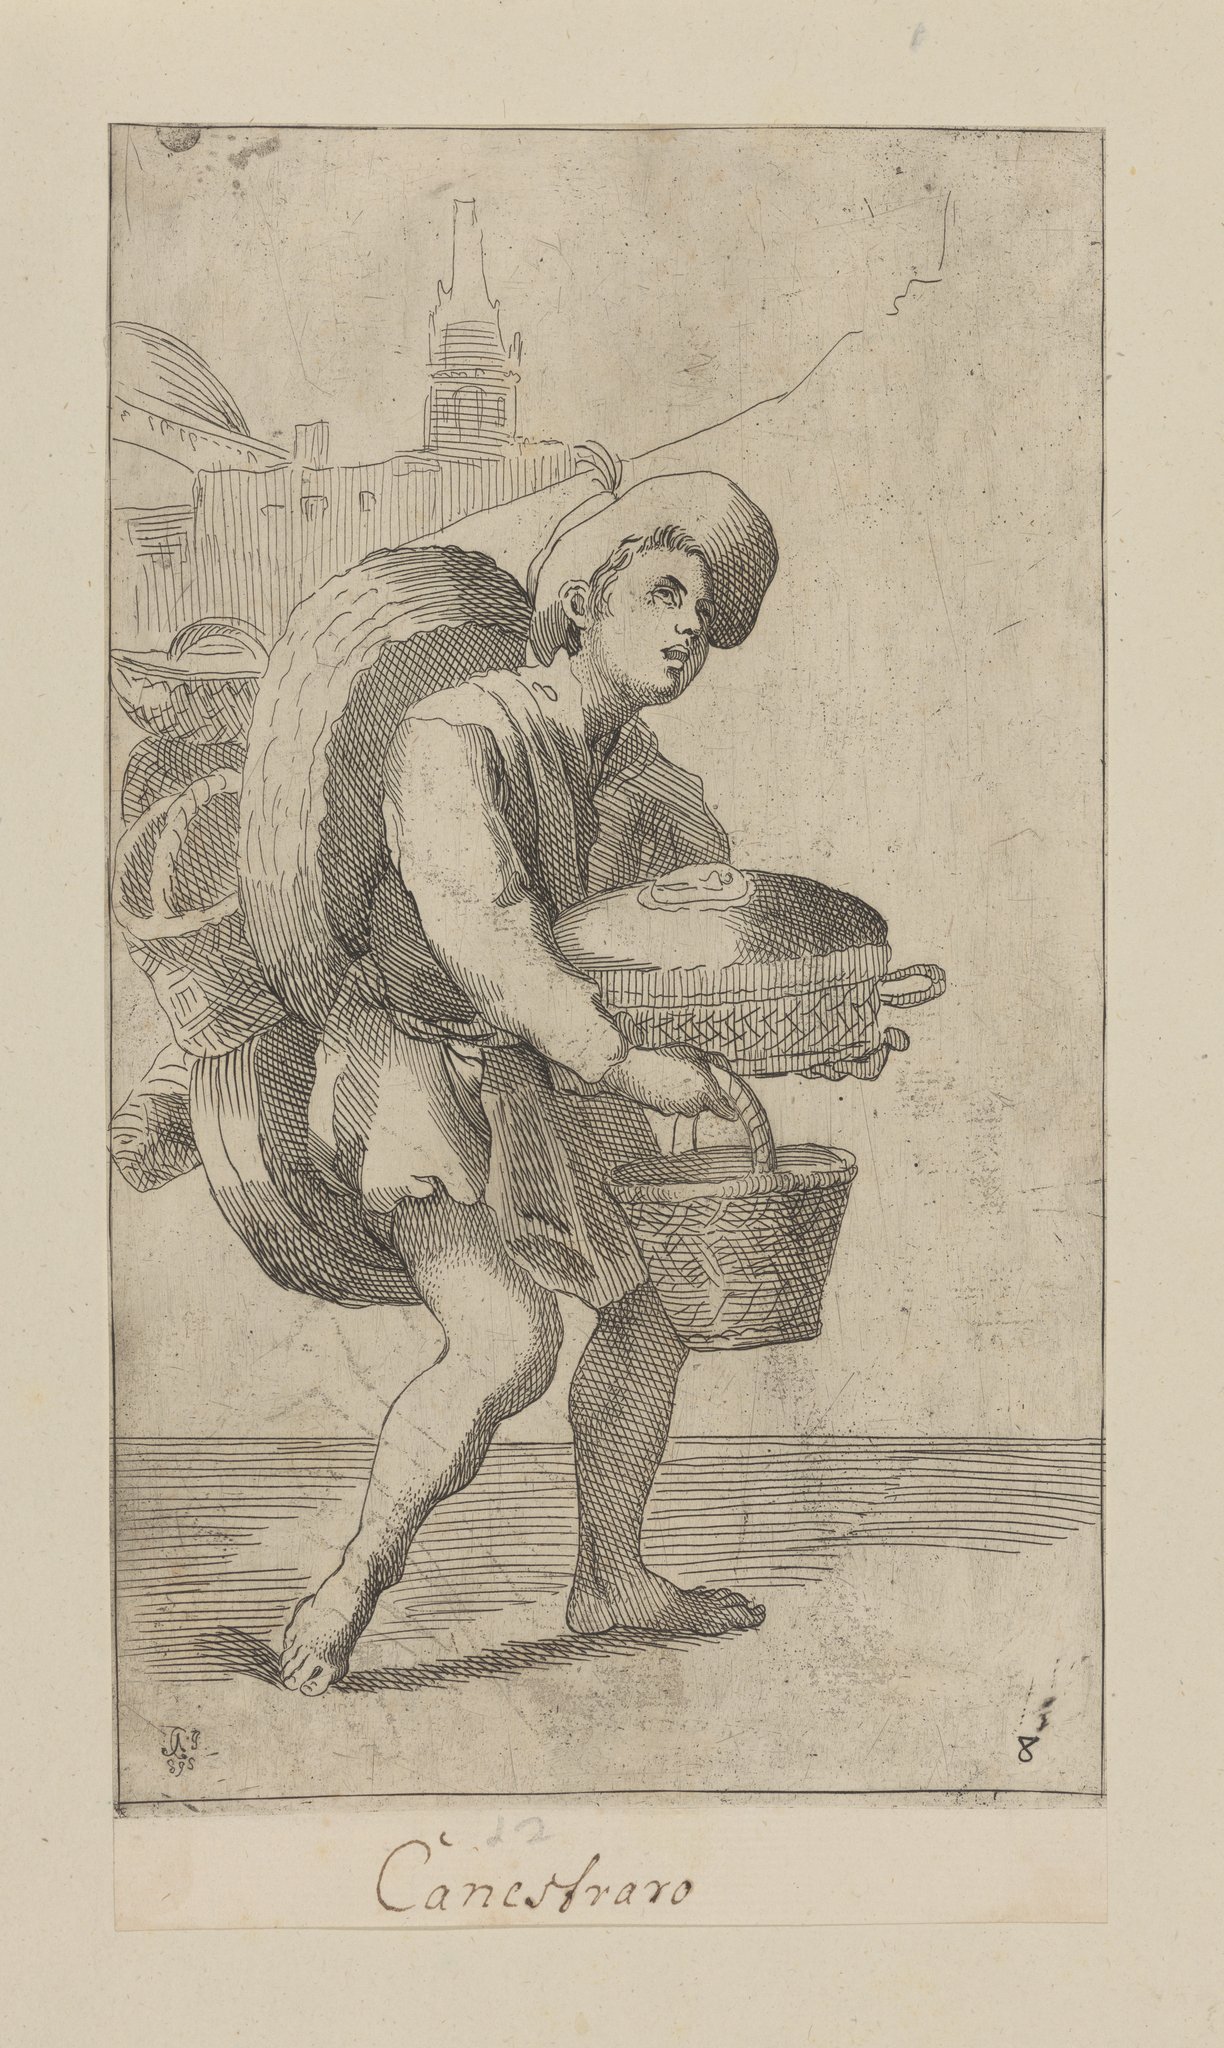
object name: print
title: Plate 8: Vendor of baskets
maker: simon guillain ii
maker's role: artist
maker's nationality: french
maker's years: 1618-1718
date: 1646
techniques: etching